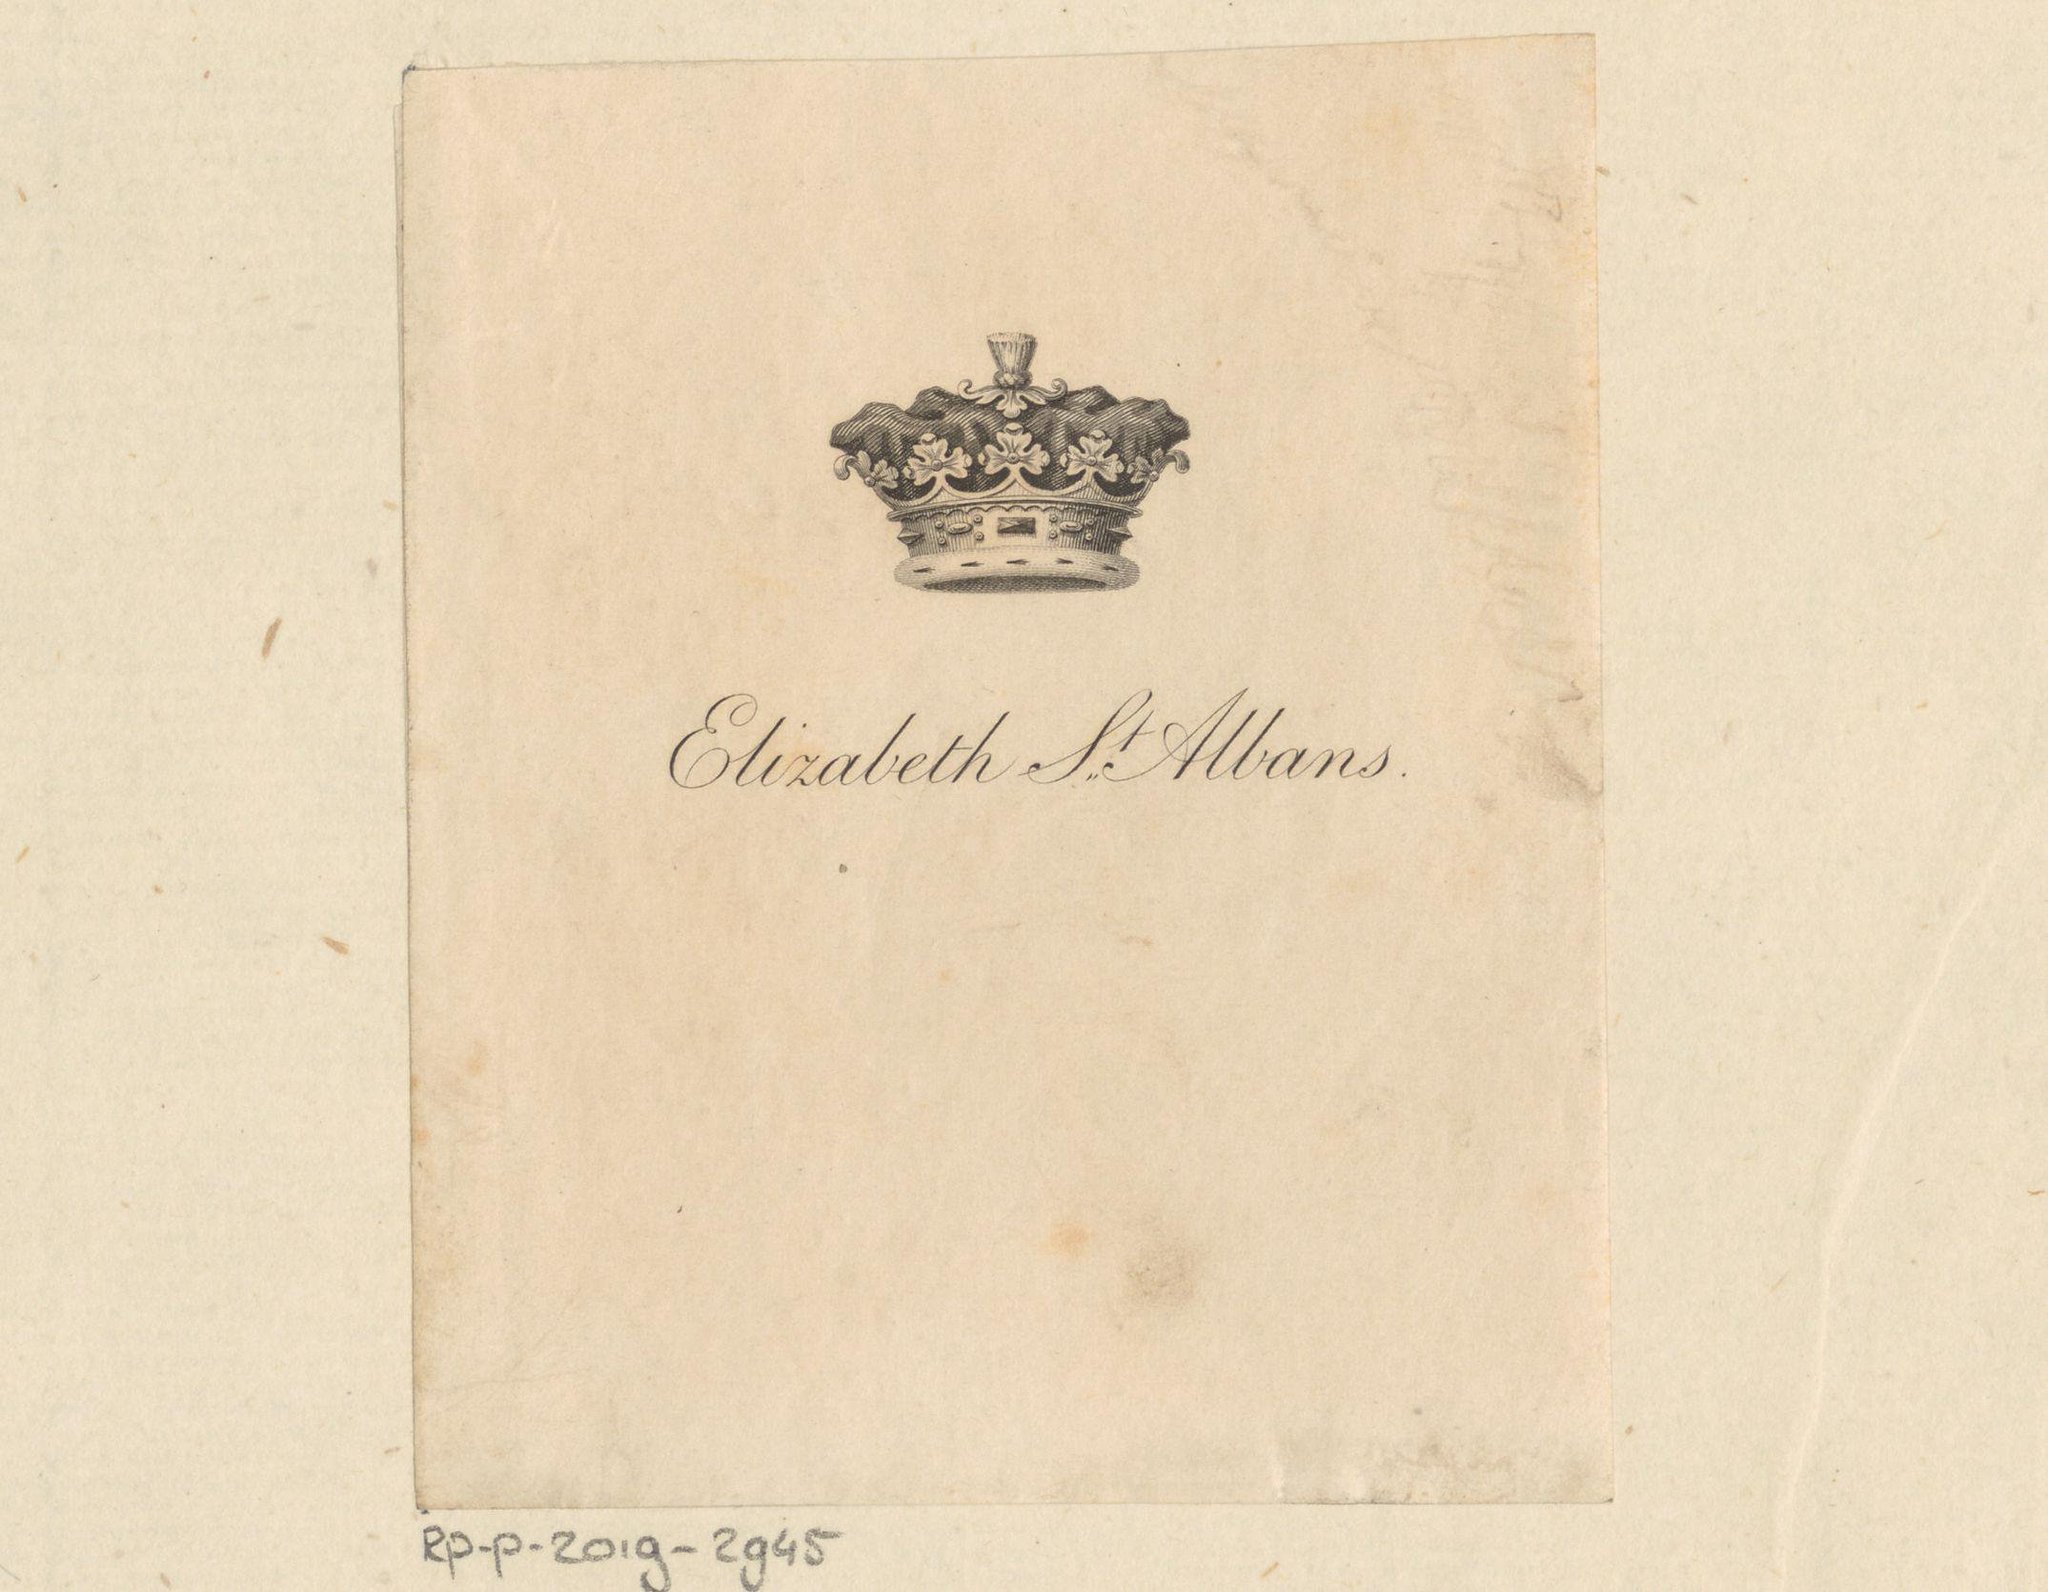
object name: bookplate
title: Ex libris van Elizabeth St. Albans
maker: Anonymous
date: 1800-1899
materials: paper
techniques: engraving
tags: crown (symbol of sovereignty)